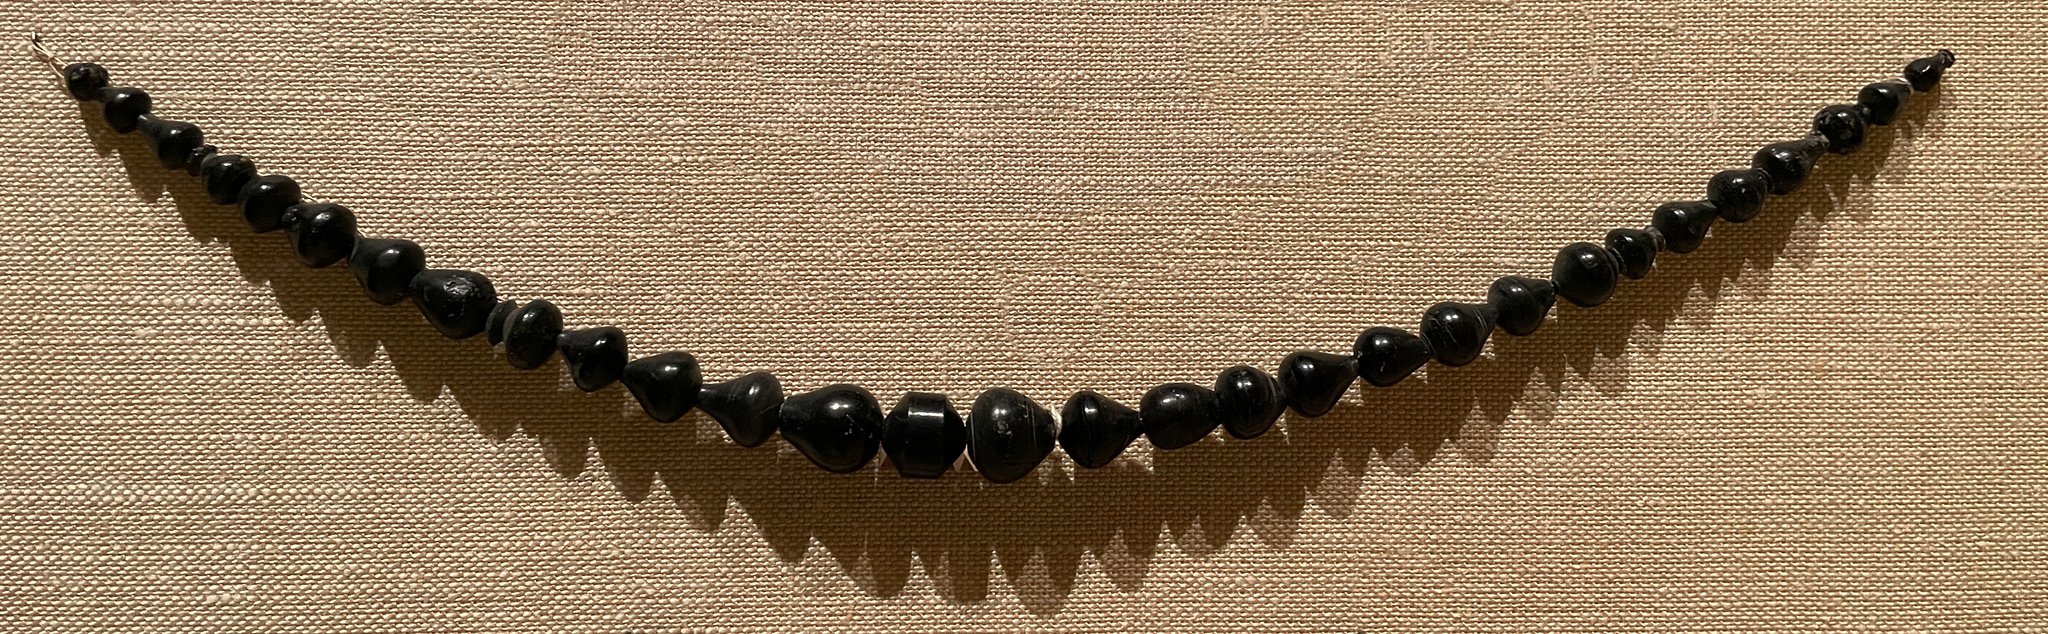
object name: bead, string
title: String of Beads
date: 701-1200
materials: stone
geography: iran